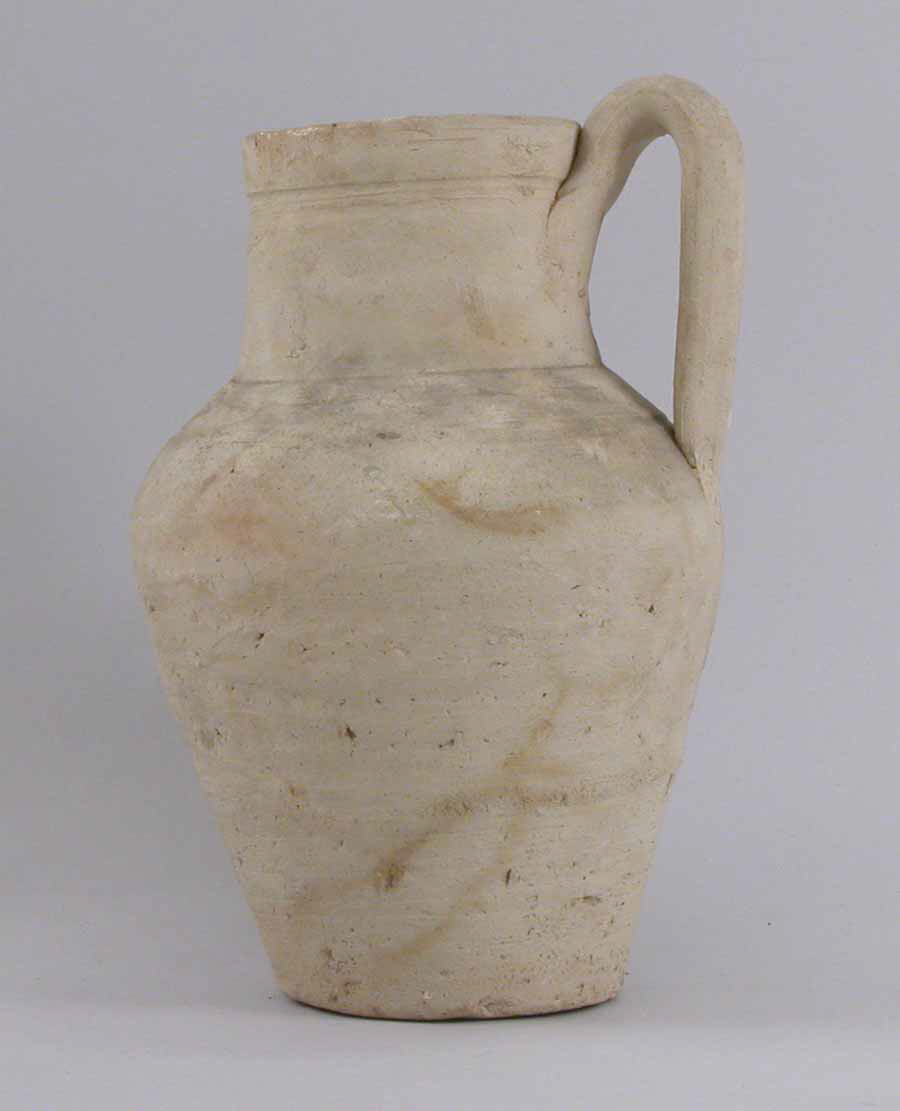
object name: ewer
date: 801-1000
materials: earthenware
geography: iran